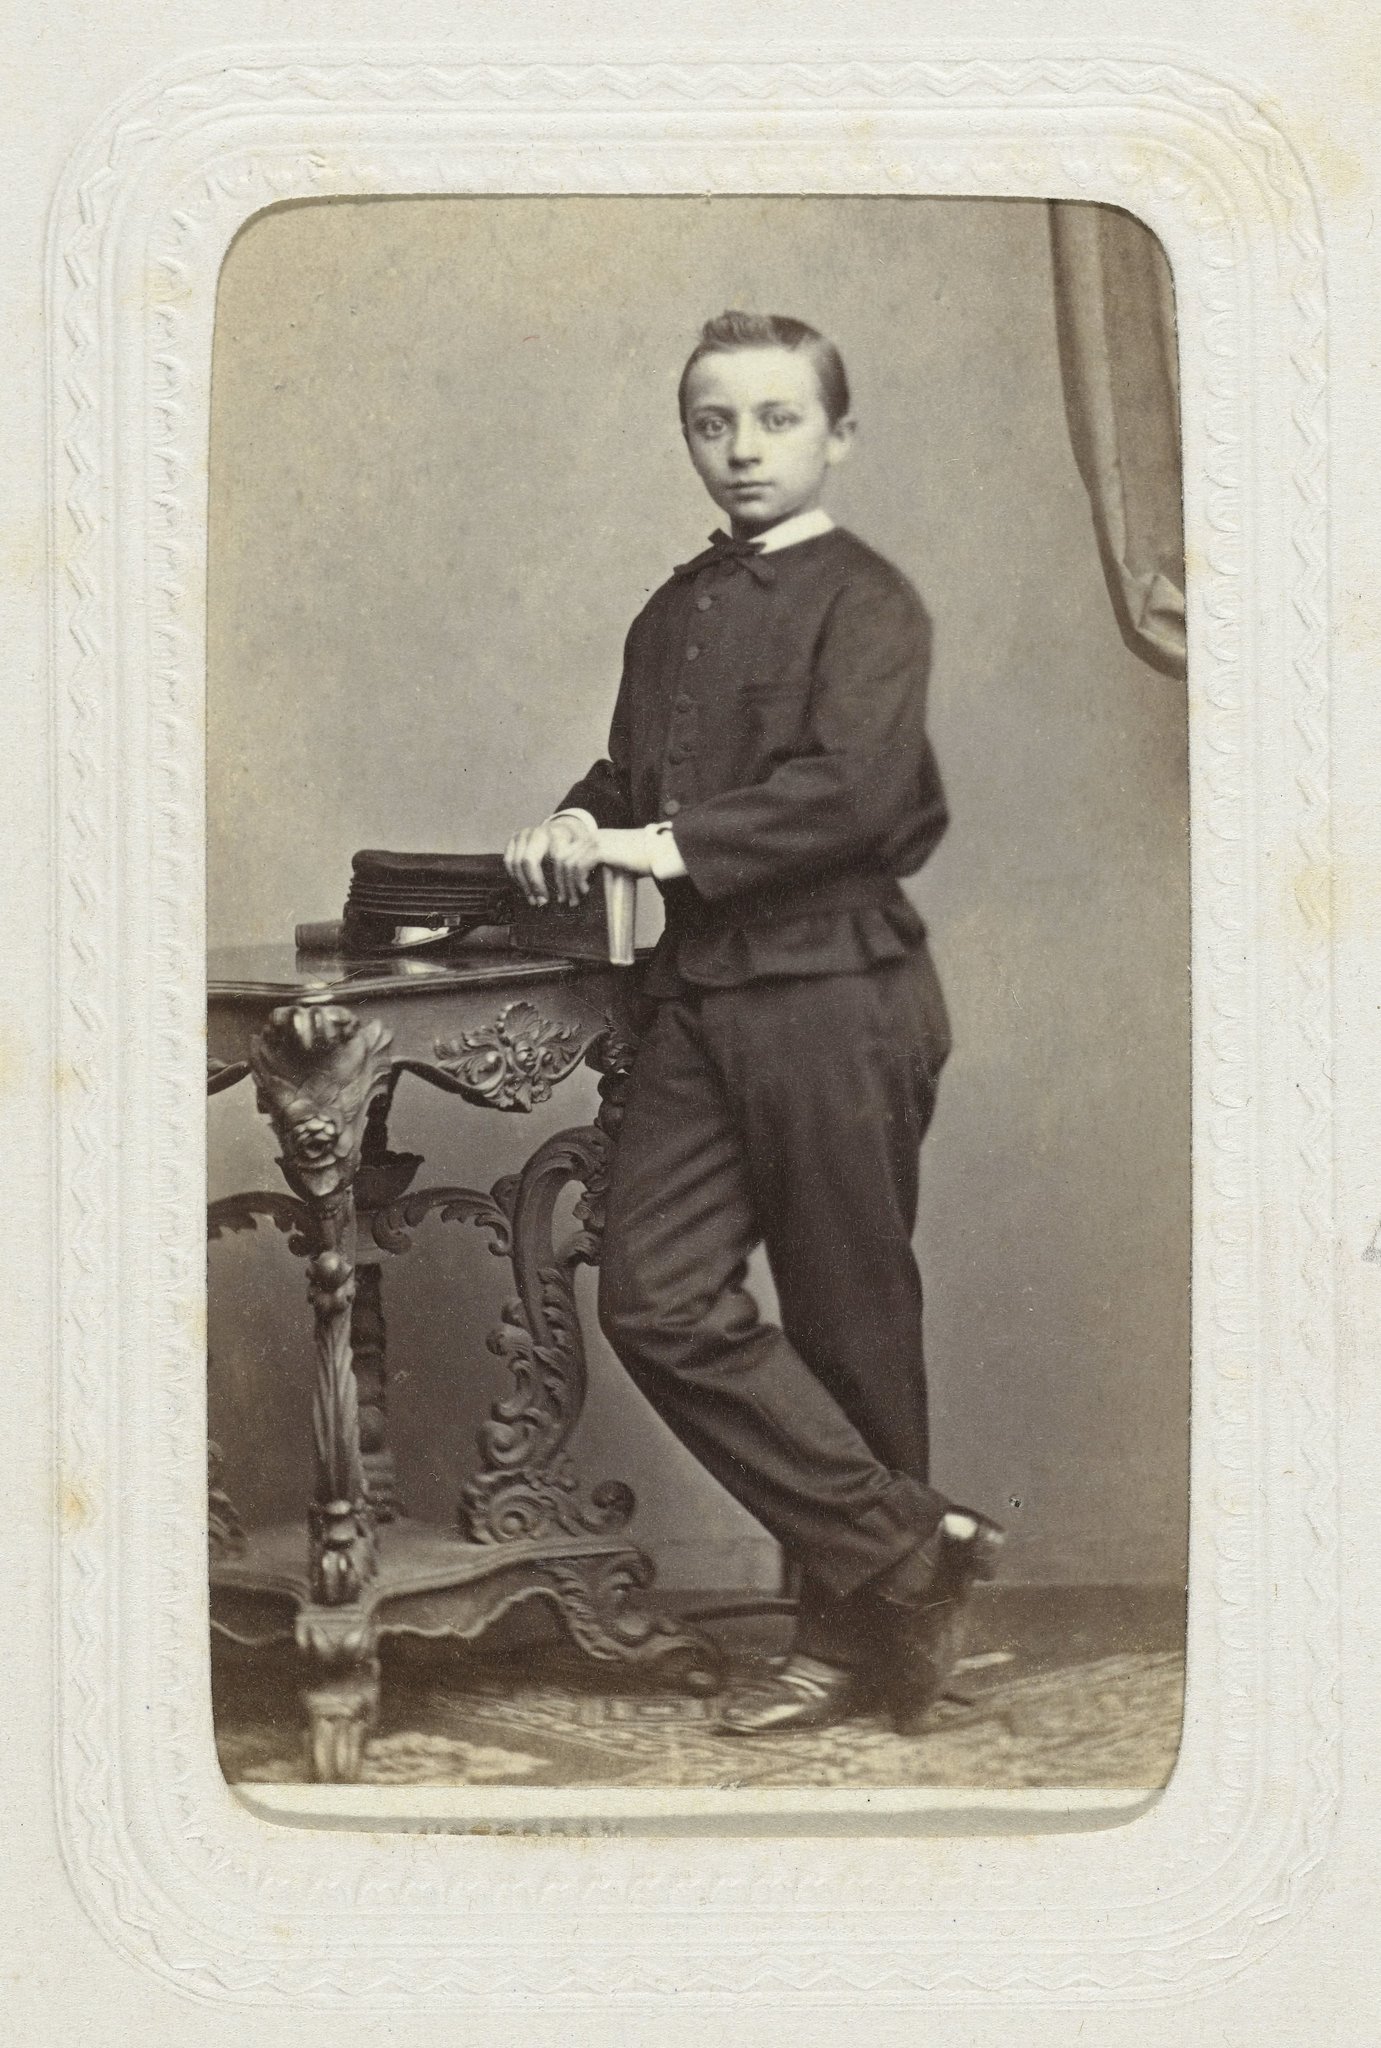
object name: carte de visite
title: Studioportret van een staande jongen bij een tafel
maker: carl rensing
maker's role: fotograaf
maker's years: 1826-1898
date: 1863-1866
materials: cardboard, paper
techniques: albumen print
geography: amsterdam